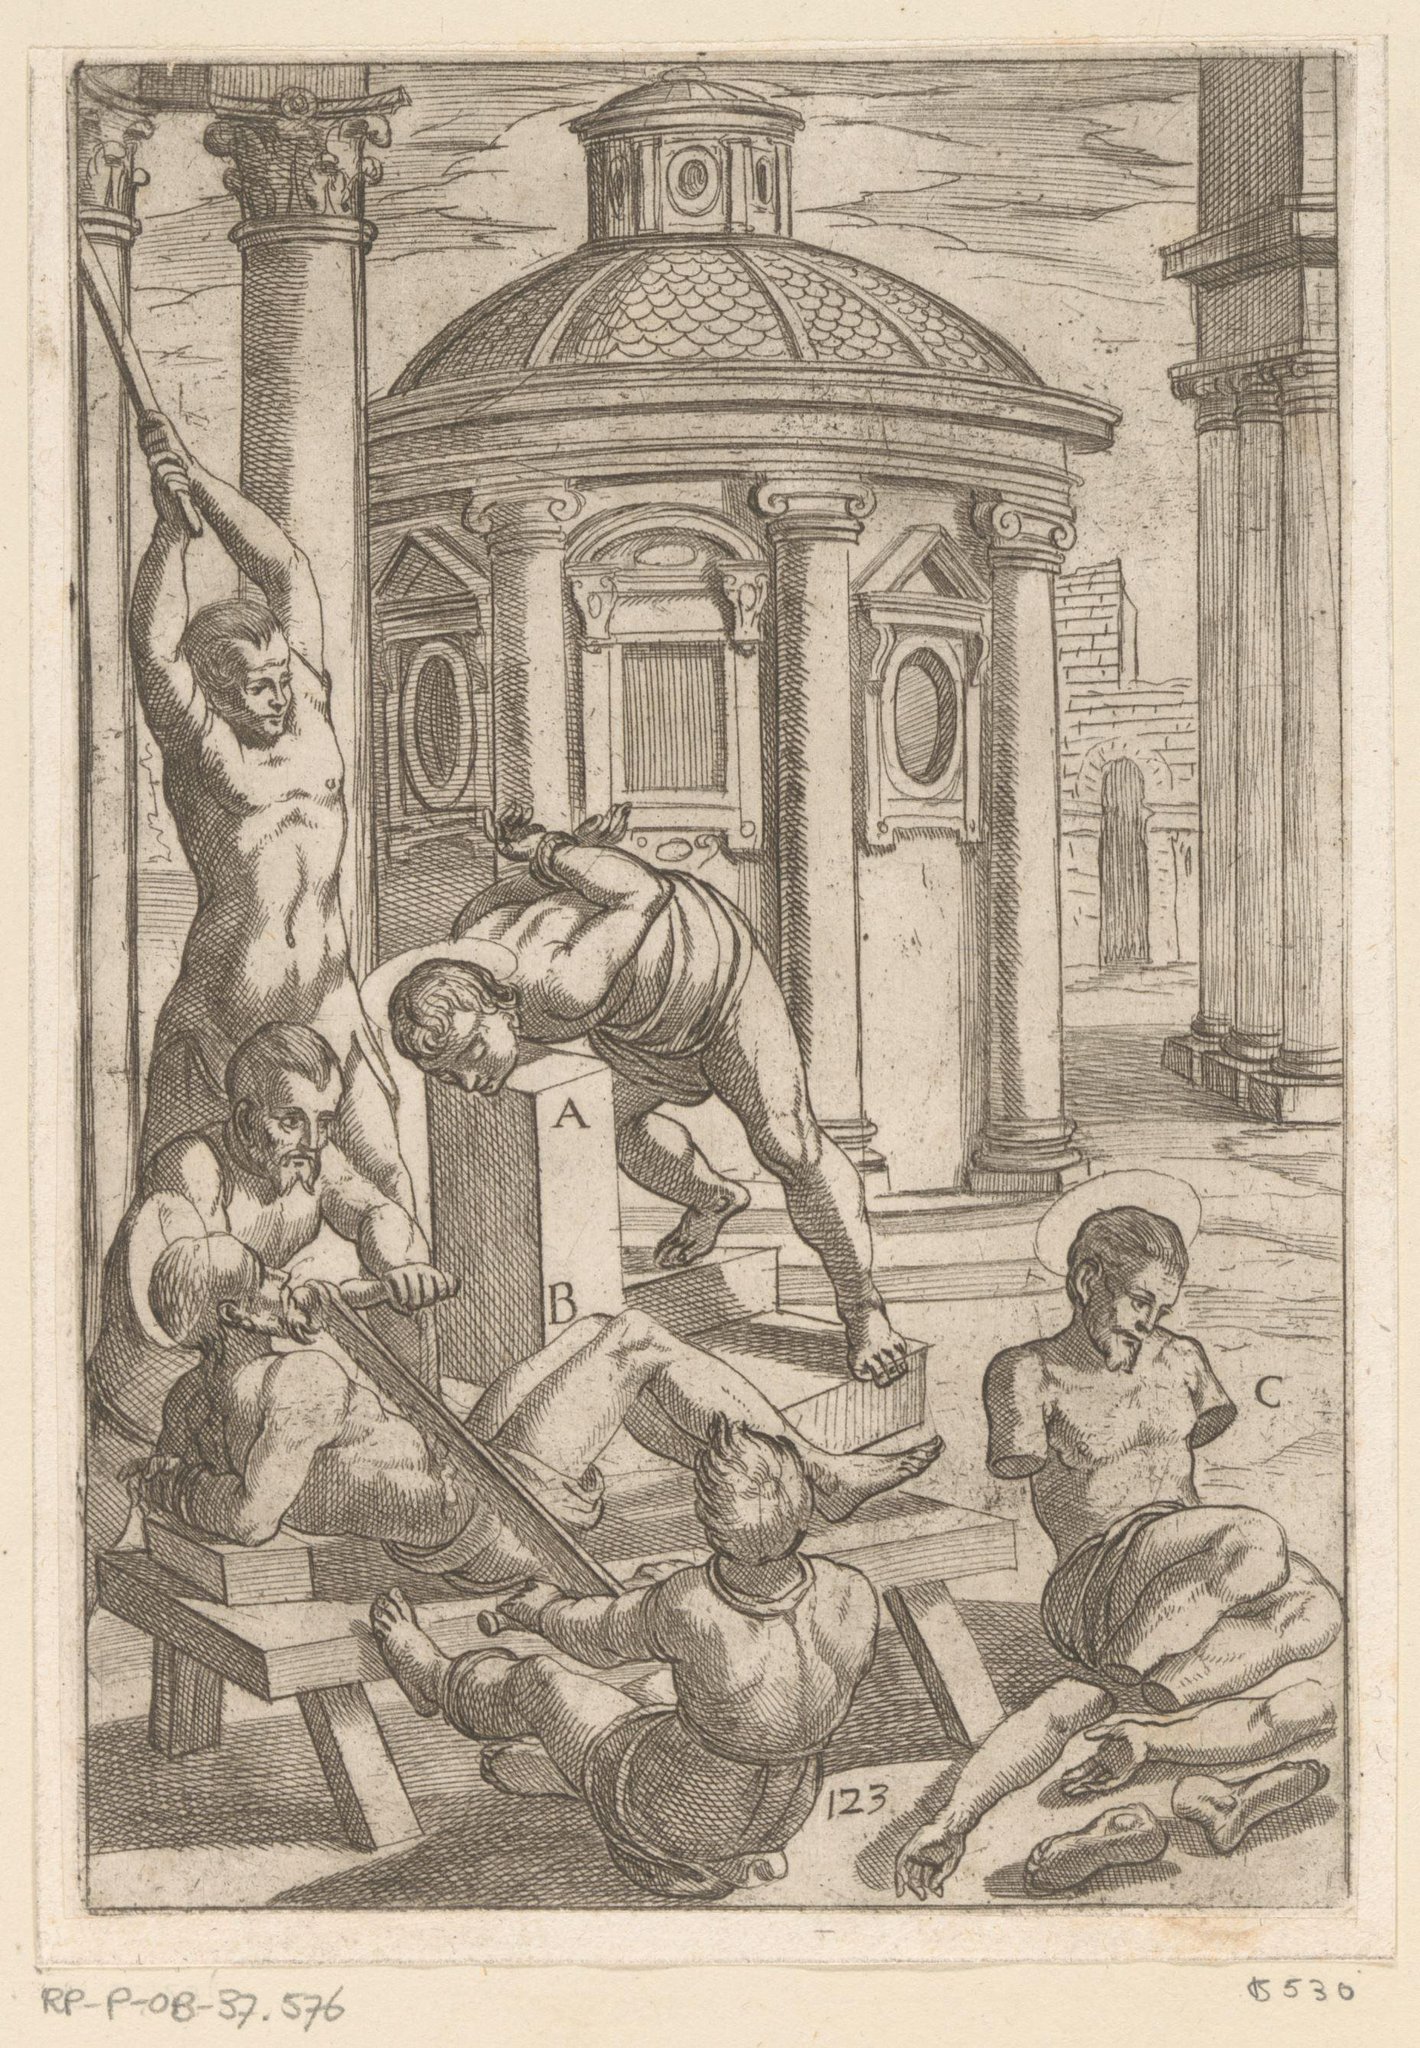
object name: print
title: Martelingen ondergaan door christelijke martelaars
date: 1565-1630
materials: paper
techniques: etching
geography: vatican city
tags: violent death ~ maltreatment, torture, torture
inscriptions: collector's mark: Lugt 240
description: Deze prent maakt deel uit van een reeks van 47 prenten (+ titelprent) met voorstellingen van martelmethoden. Deze prenten zijn in een andere editie gebruikt als illustraties voor Antonio Gallonio's 'Trattato degli Instrumenti di Martirio e delle Varie Maniere di Martoriare Usate dai Gentili contro Christiani' (Rome, Ascanio en Girolamo Dongangeli, 1591).